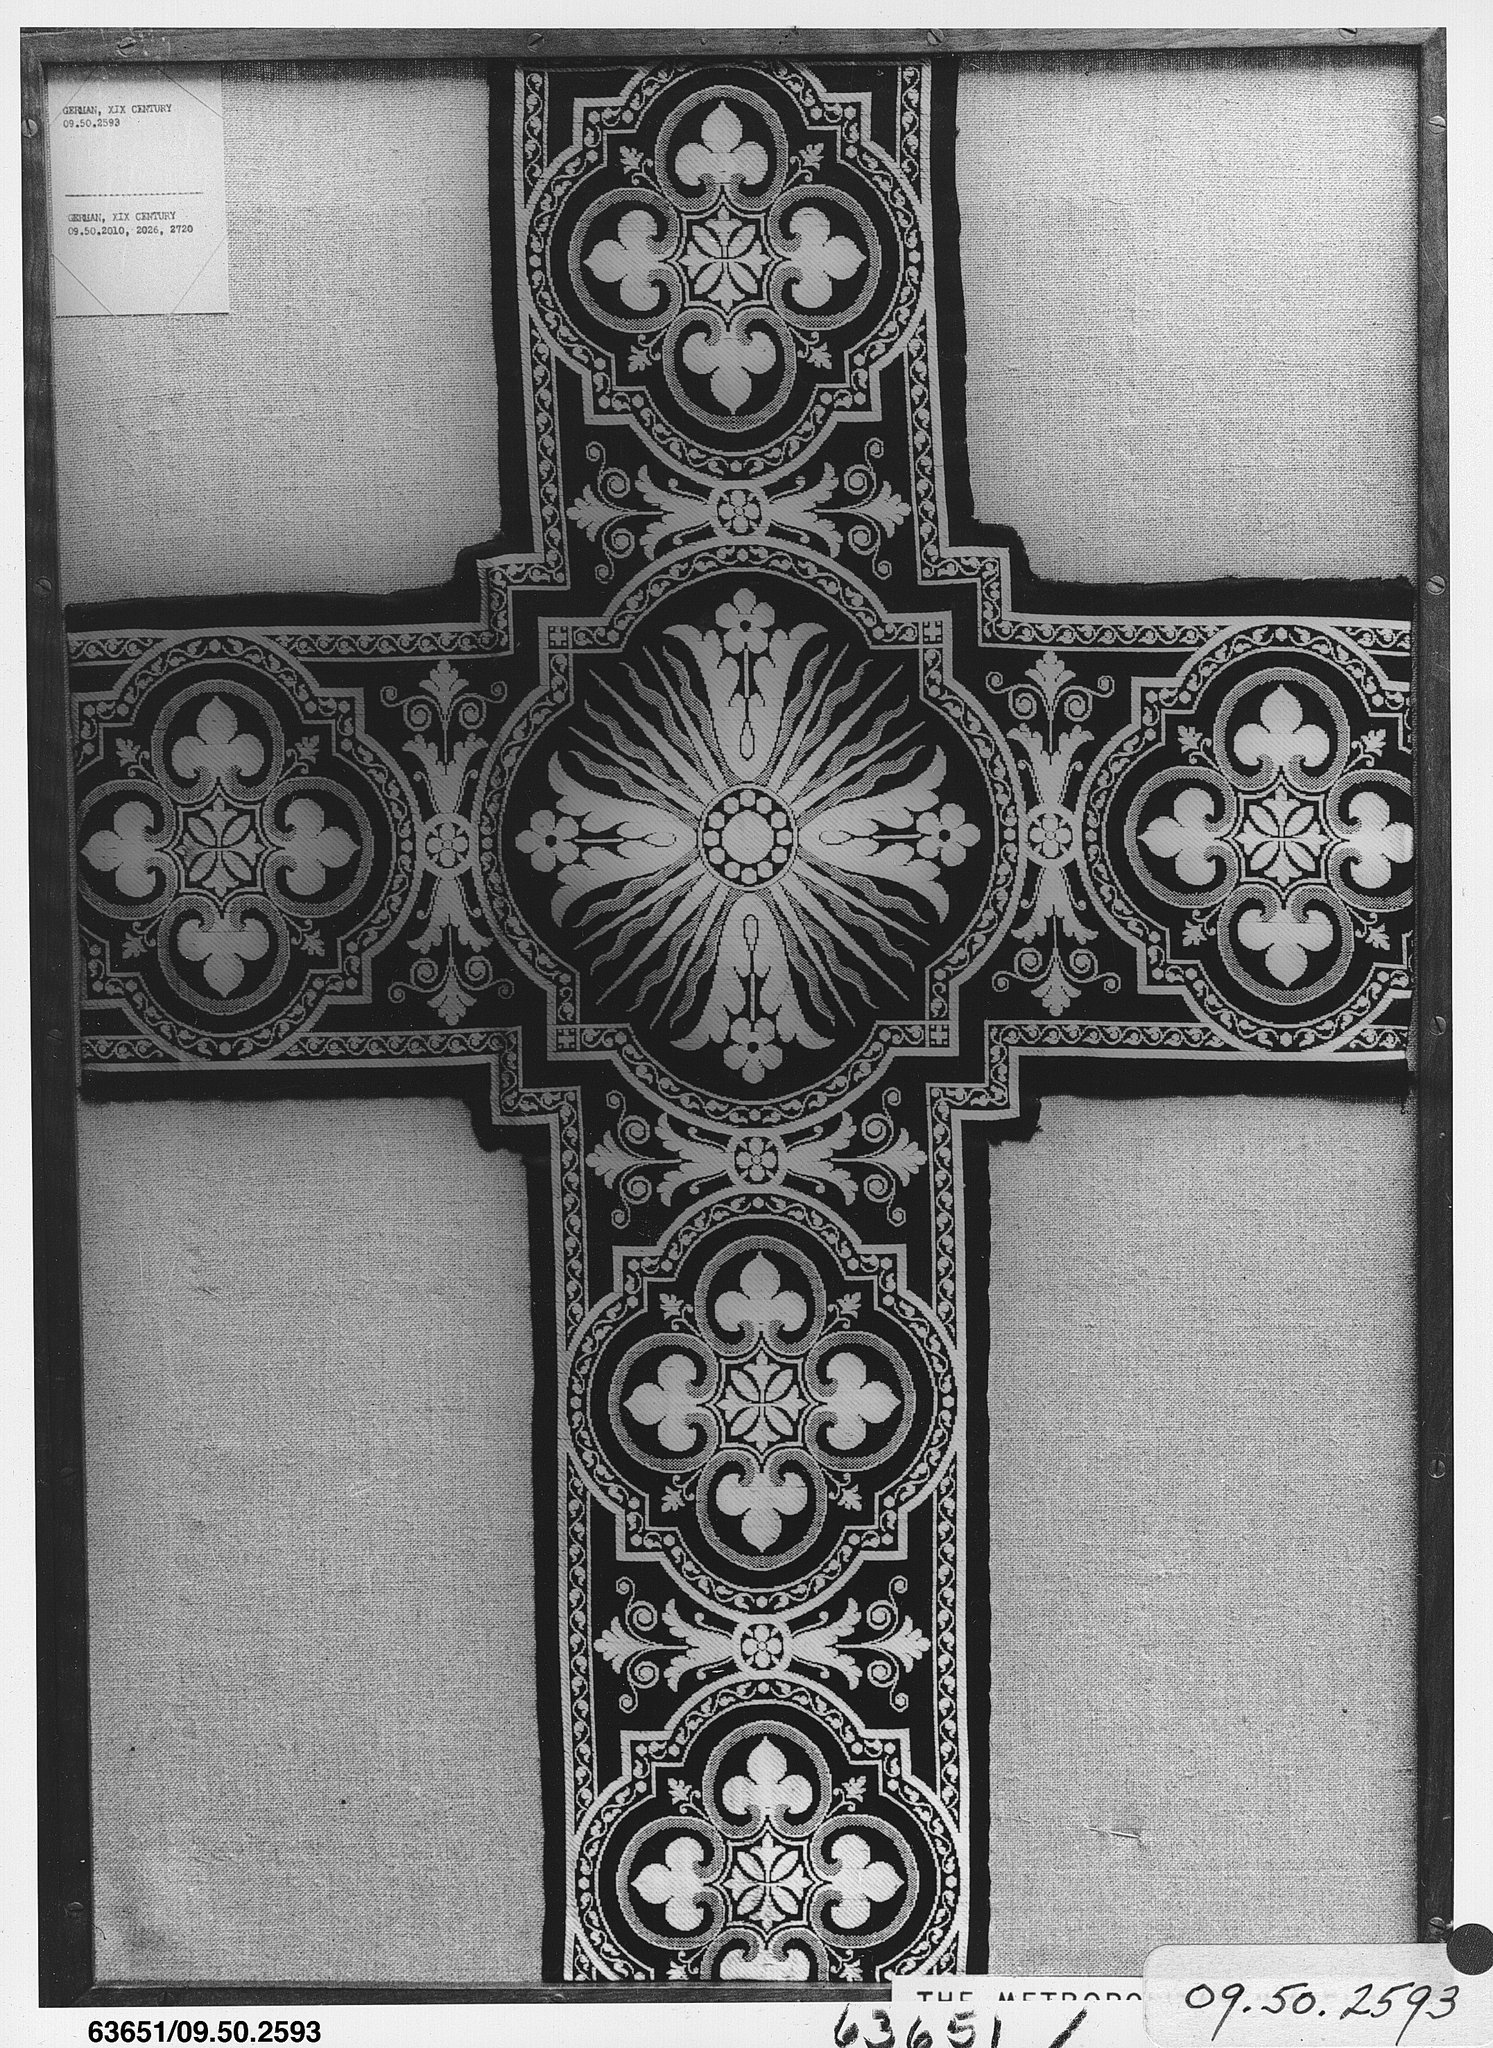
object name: orphrey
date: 1801-1900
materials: silk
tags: cross